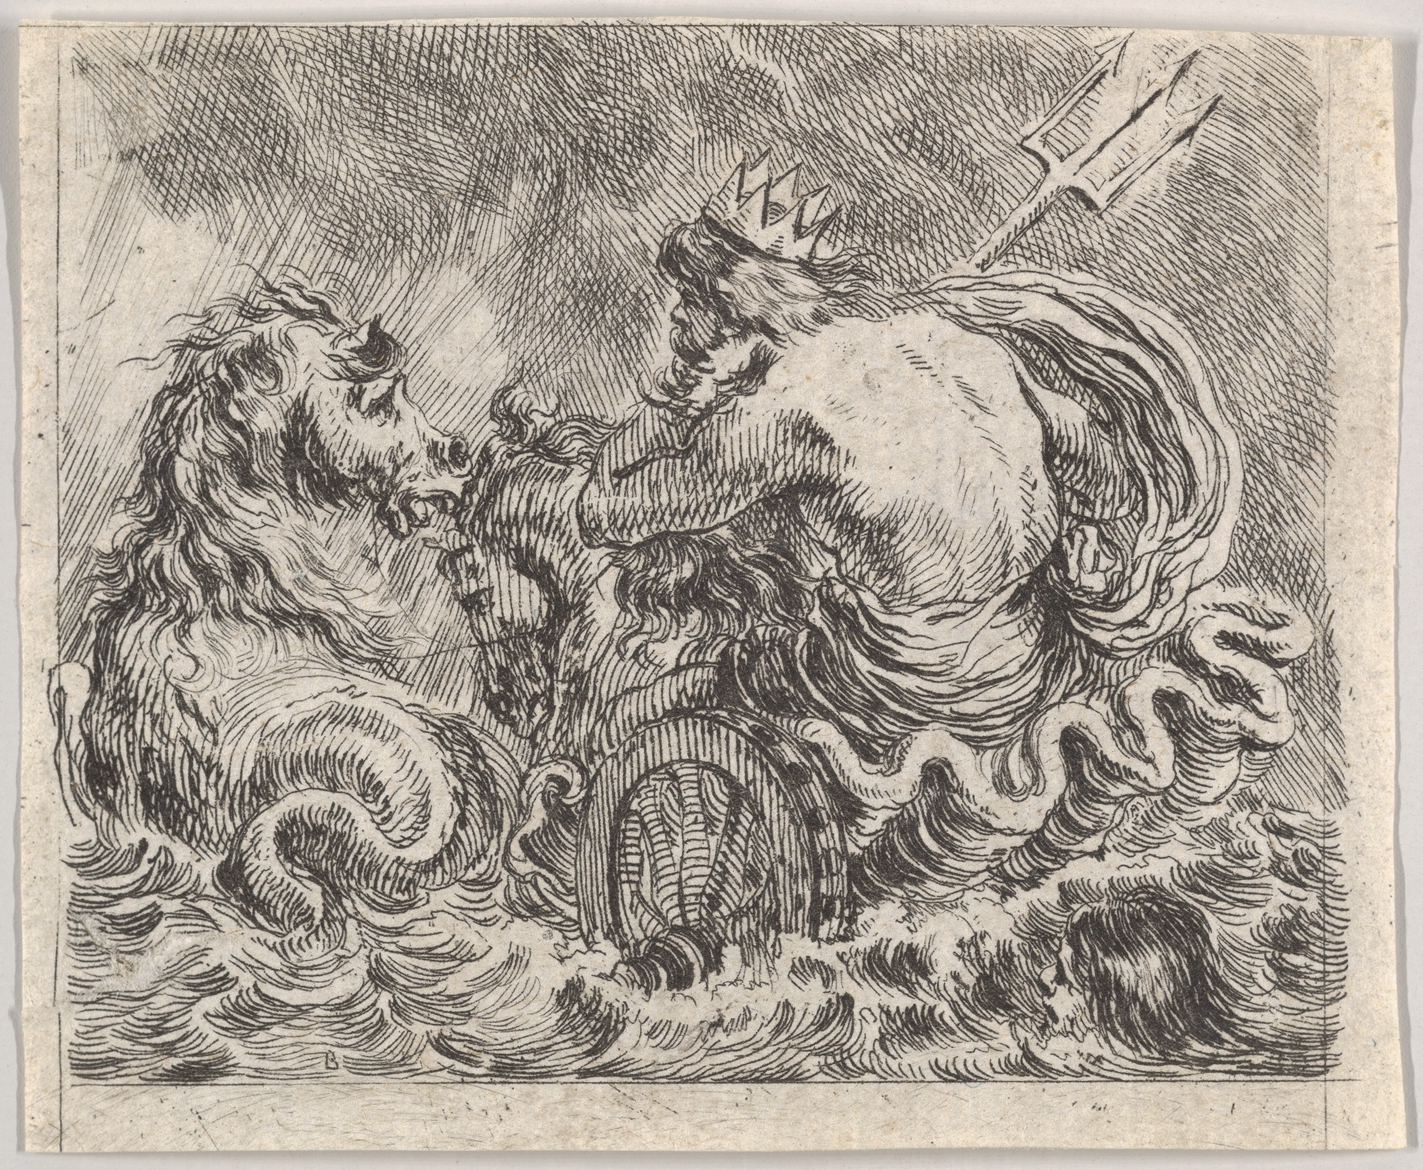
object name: print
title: Neptune, from "Game of Mythology" (Jeu de la Mythologie)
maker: stefano della bella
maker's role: artist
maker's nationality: italian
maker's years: 1610-1664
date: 1644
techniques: etching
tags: neptune,horses